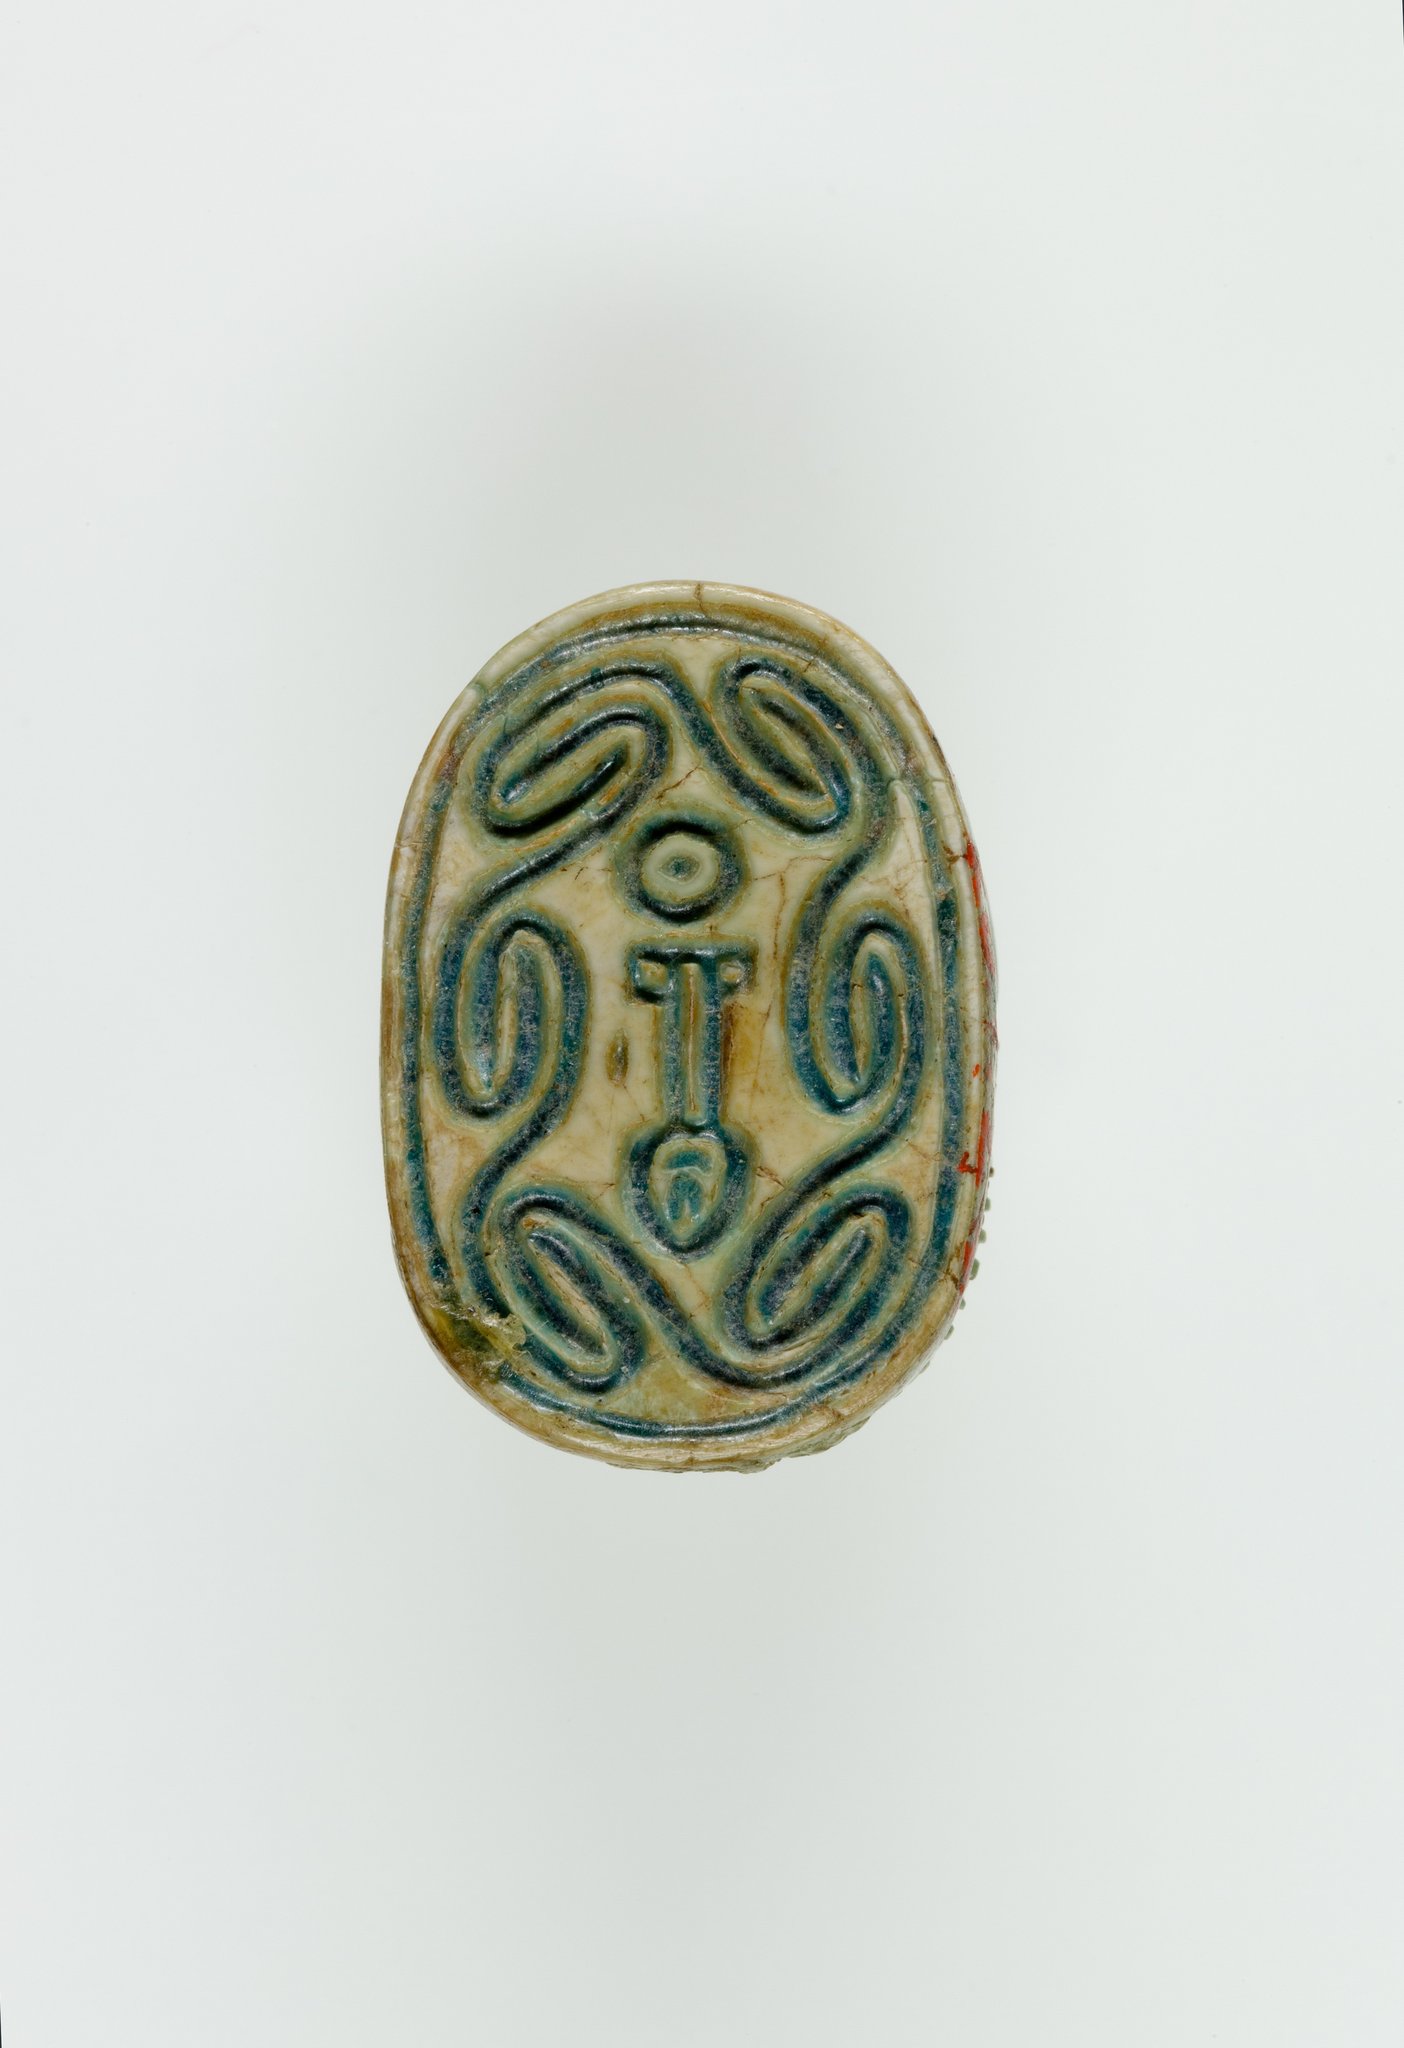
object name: scarab, nefer, scroll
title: Scarab Incised with Hieroglyphs in Scroll Border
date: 1850-1640 BCE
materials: stone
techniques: glazing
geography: egypt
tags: scarabs